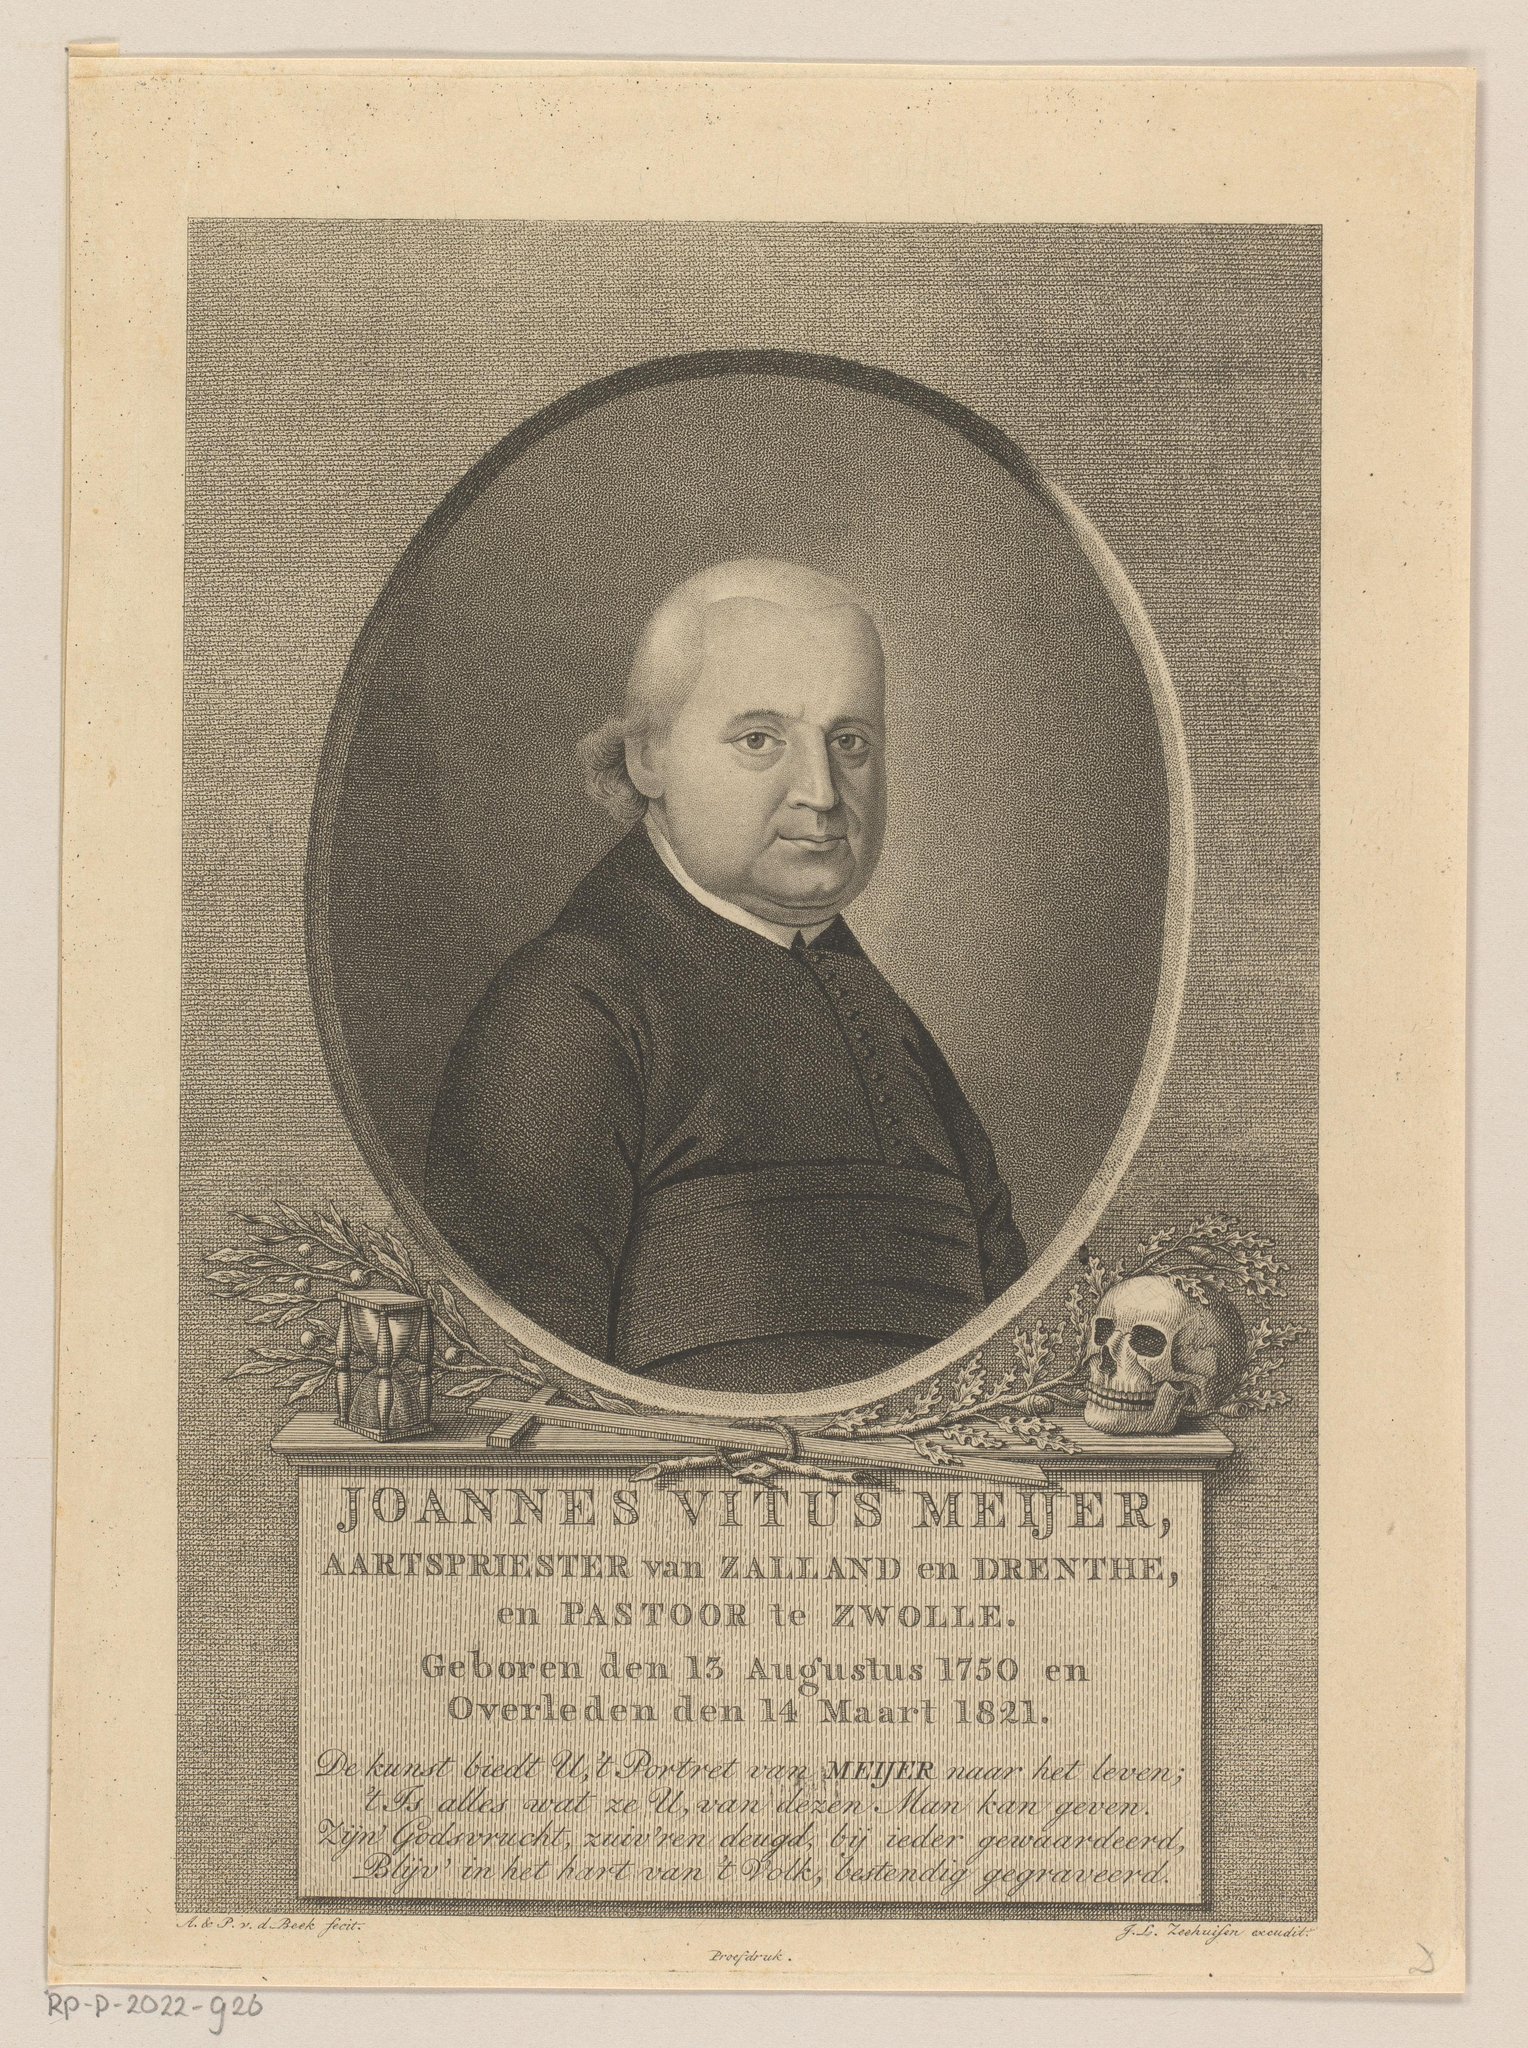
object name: print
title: Joannes Vitus Meijer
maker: joh. louis zeehuisen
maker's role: publisher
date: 1821-1852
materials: paper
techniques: engraving, etching, roulette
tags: historical persons, chief priests ~ hierarchy of priests